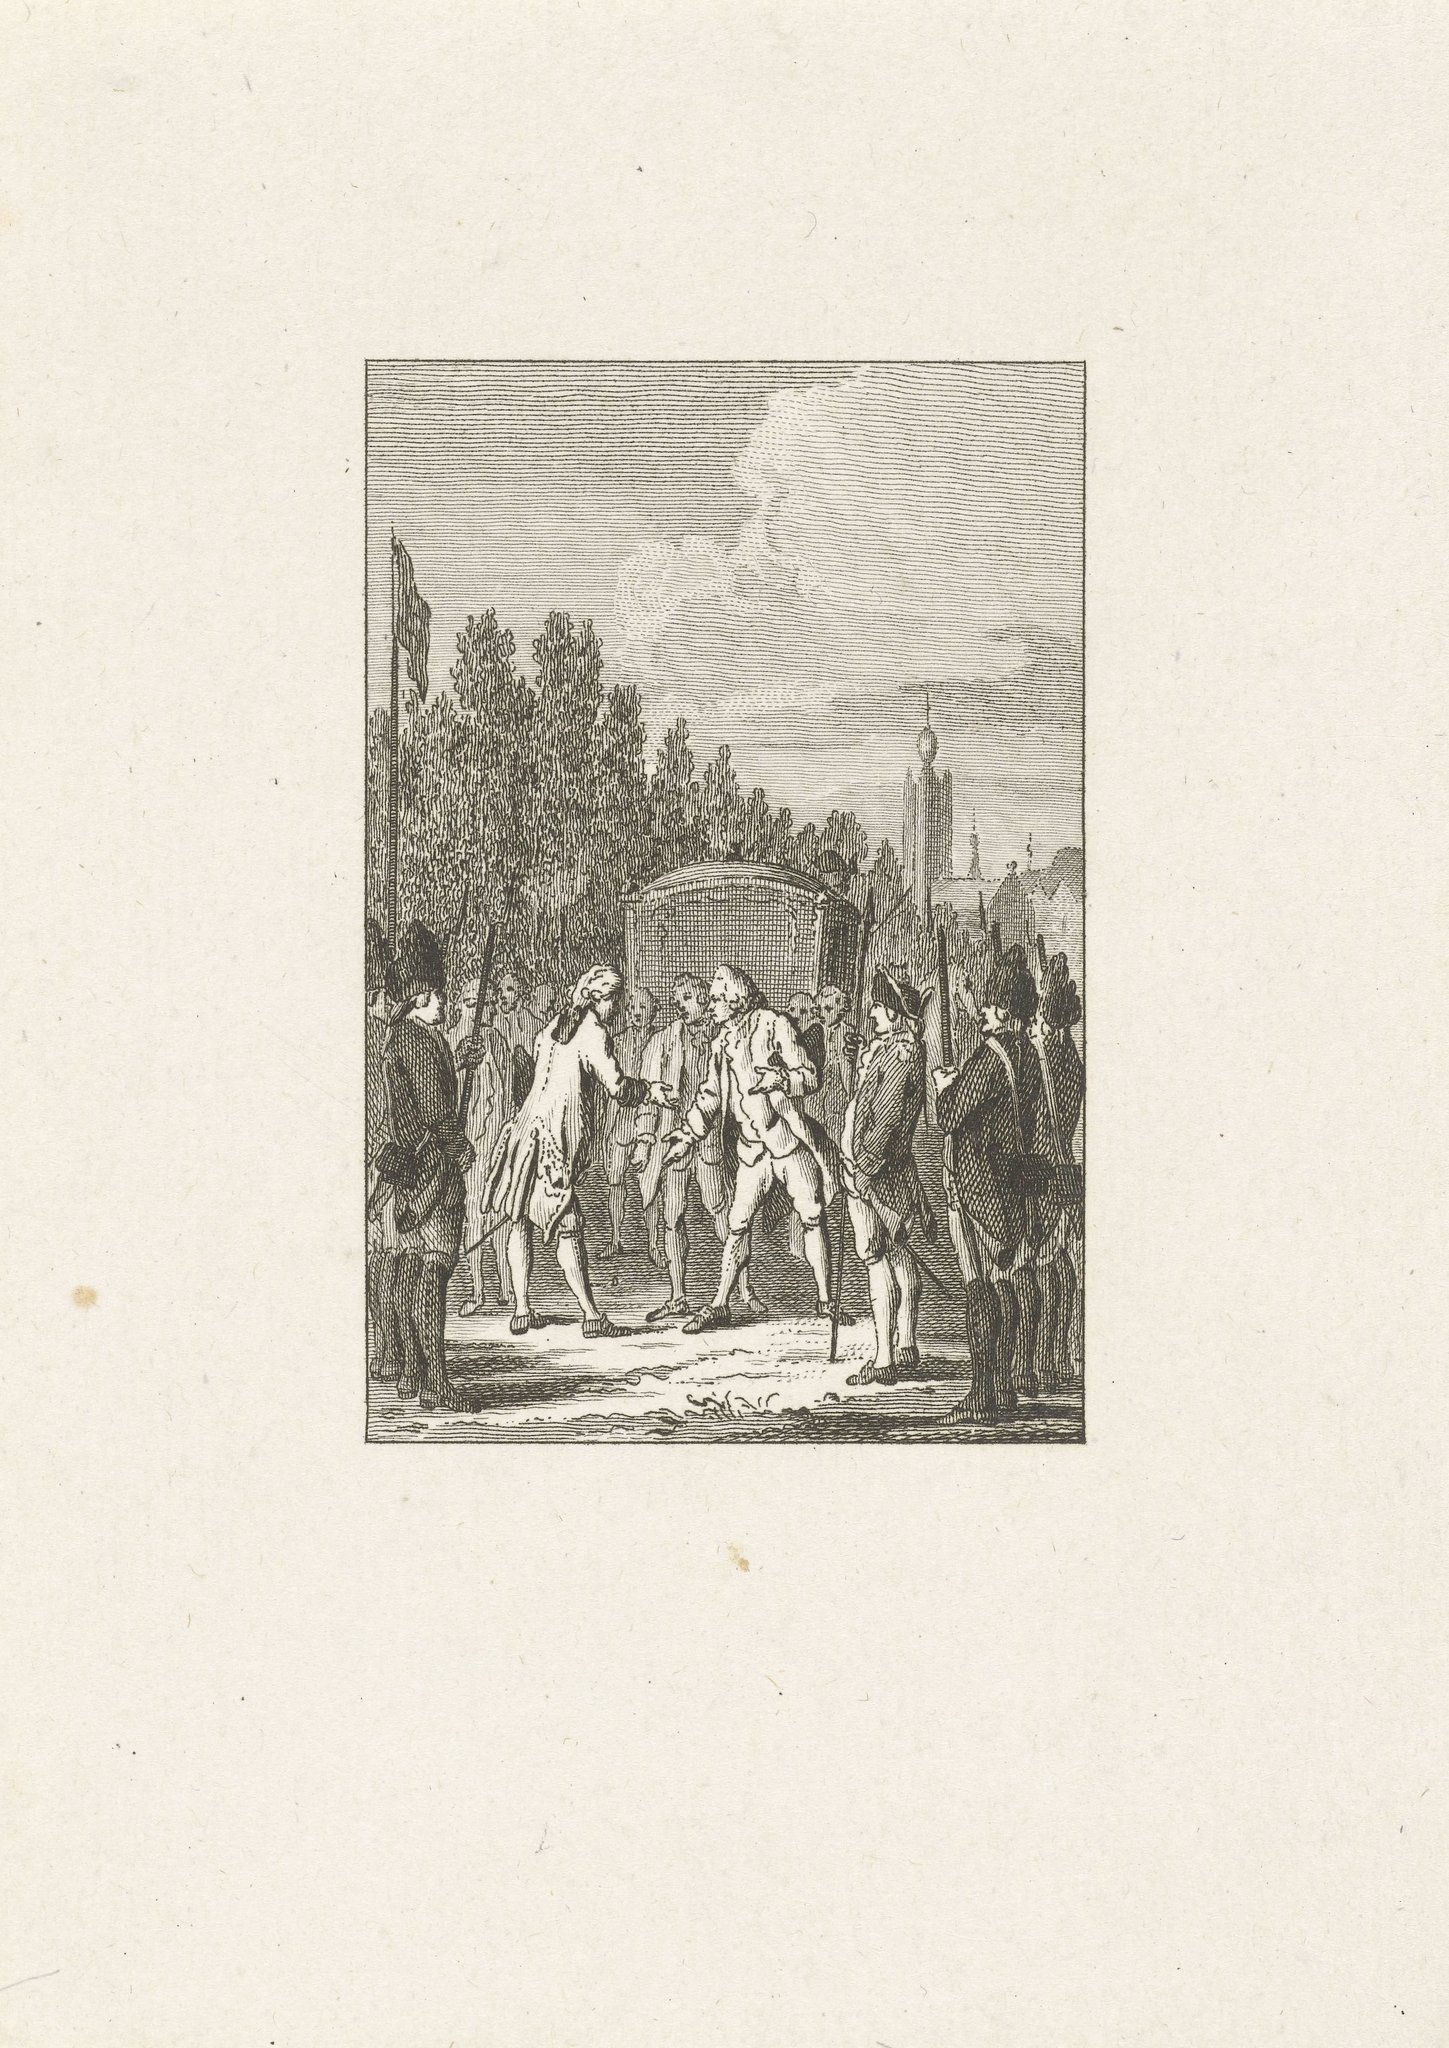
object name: print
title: Intrede van de Franse ambassadeur De Bonac te Delft, 1753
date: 1780-1795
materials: paper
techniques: etching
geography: northern netherlands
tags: reception ~ ambassador, delft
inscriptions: collector's mark: Lugt 2228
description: Ontvangst van de Franse ambassadeur de Marquis de Bonac te Delft op 20 april 1753. De ambassadeur wordt bij zijn rijtuig verwelkomd door een gezant van de burgemeester van de stad. Gemerkt rechtsboven: XII.D.Pl.II.